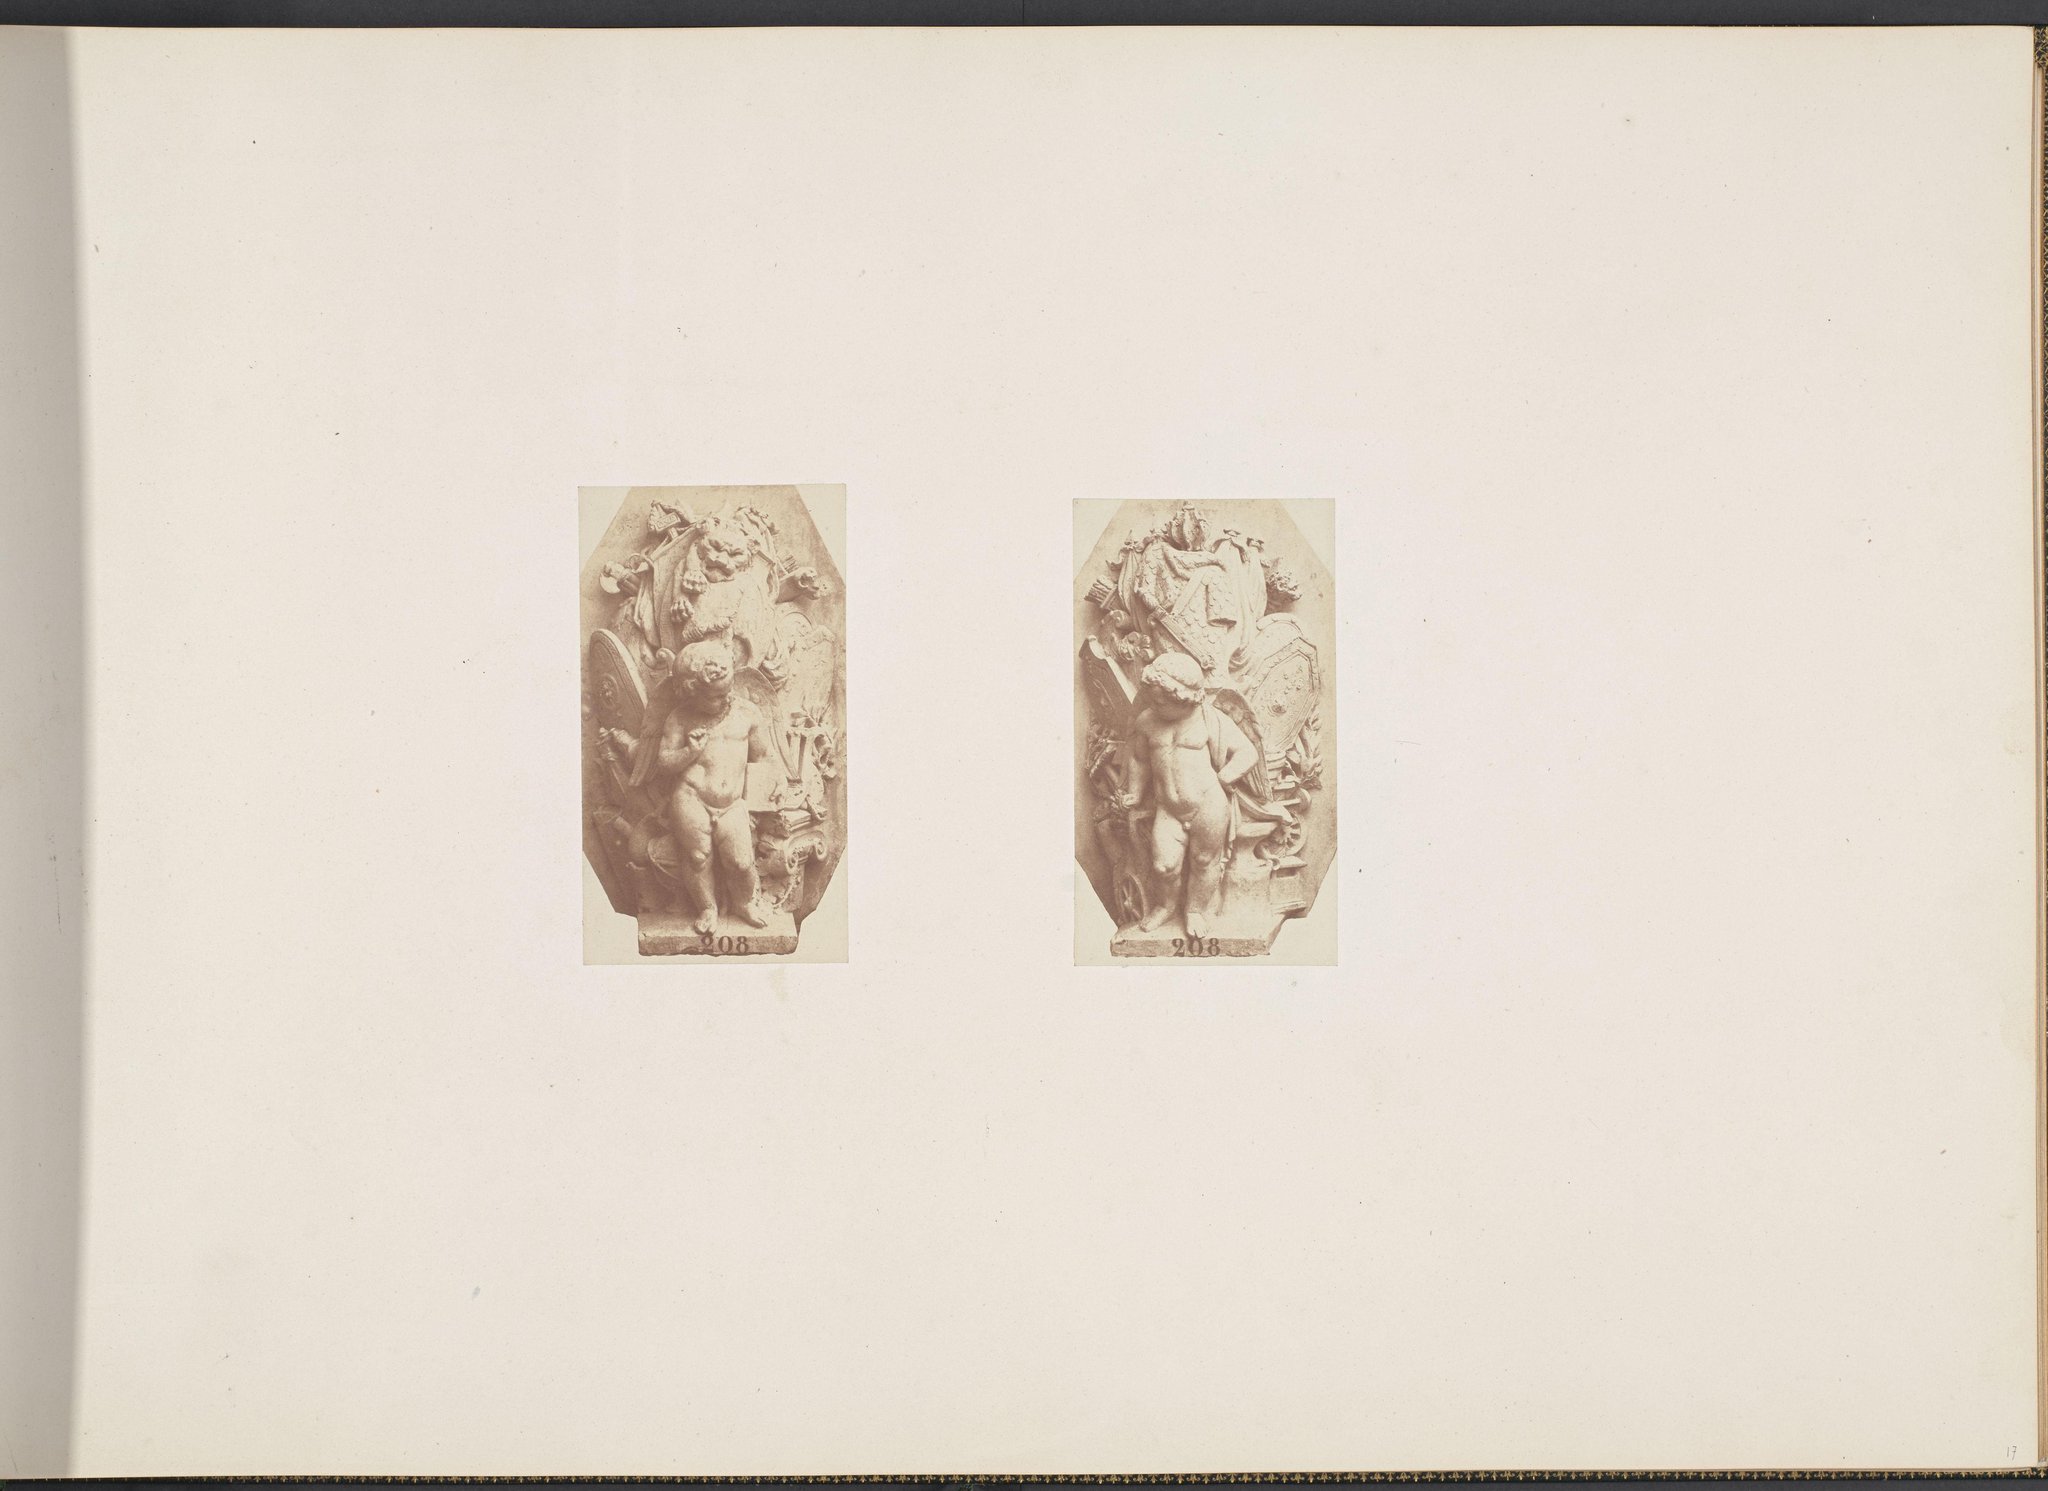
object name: photograph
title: Gipsmodellen voor beeldhouwwerken op het Palais du Louvre: "Enfant et attributs" door Georges Diébolt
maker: édouard denis baldus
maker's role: fotograaf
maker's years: 1813-1889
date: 1855-1857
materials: paper, photographic support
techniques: salted paper print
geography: paris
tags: tower, clock tower ~ monumental adornment, permanent exhibition, museum, paris, tuileries palace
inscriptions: number: ‘208’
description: Onderdeel van Réunion des Tuileries au Louvre 1852-1857, album 1.